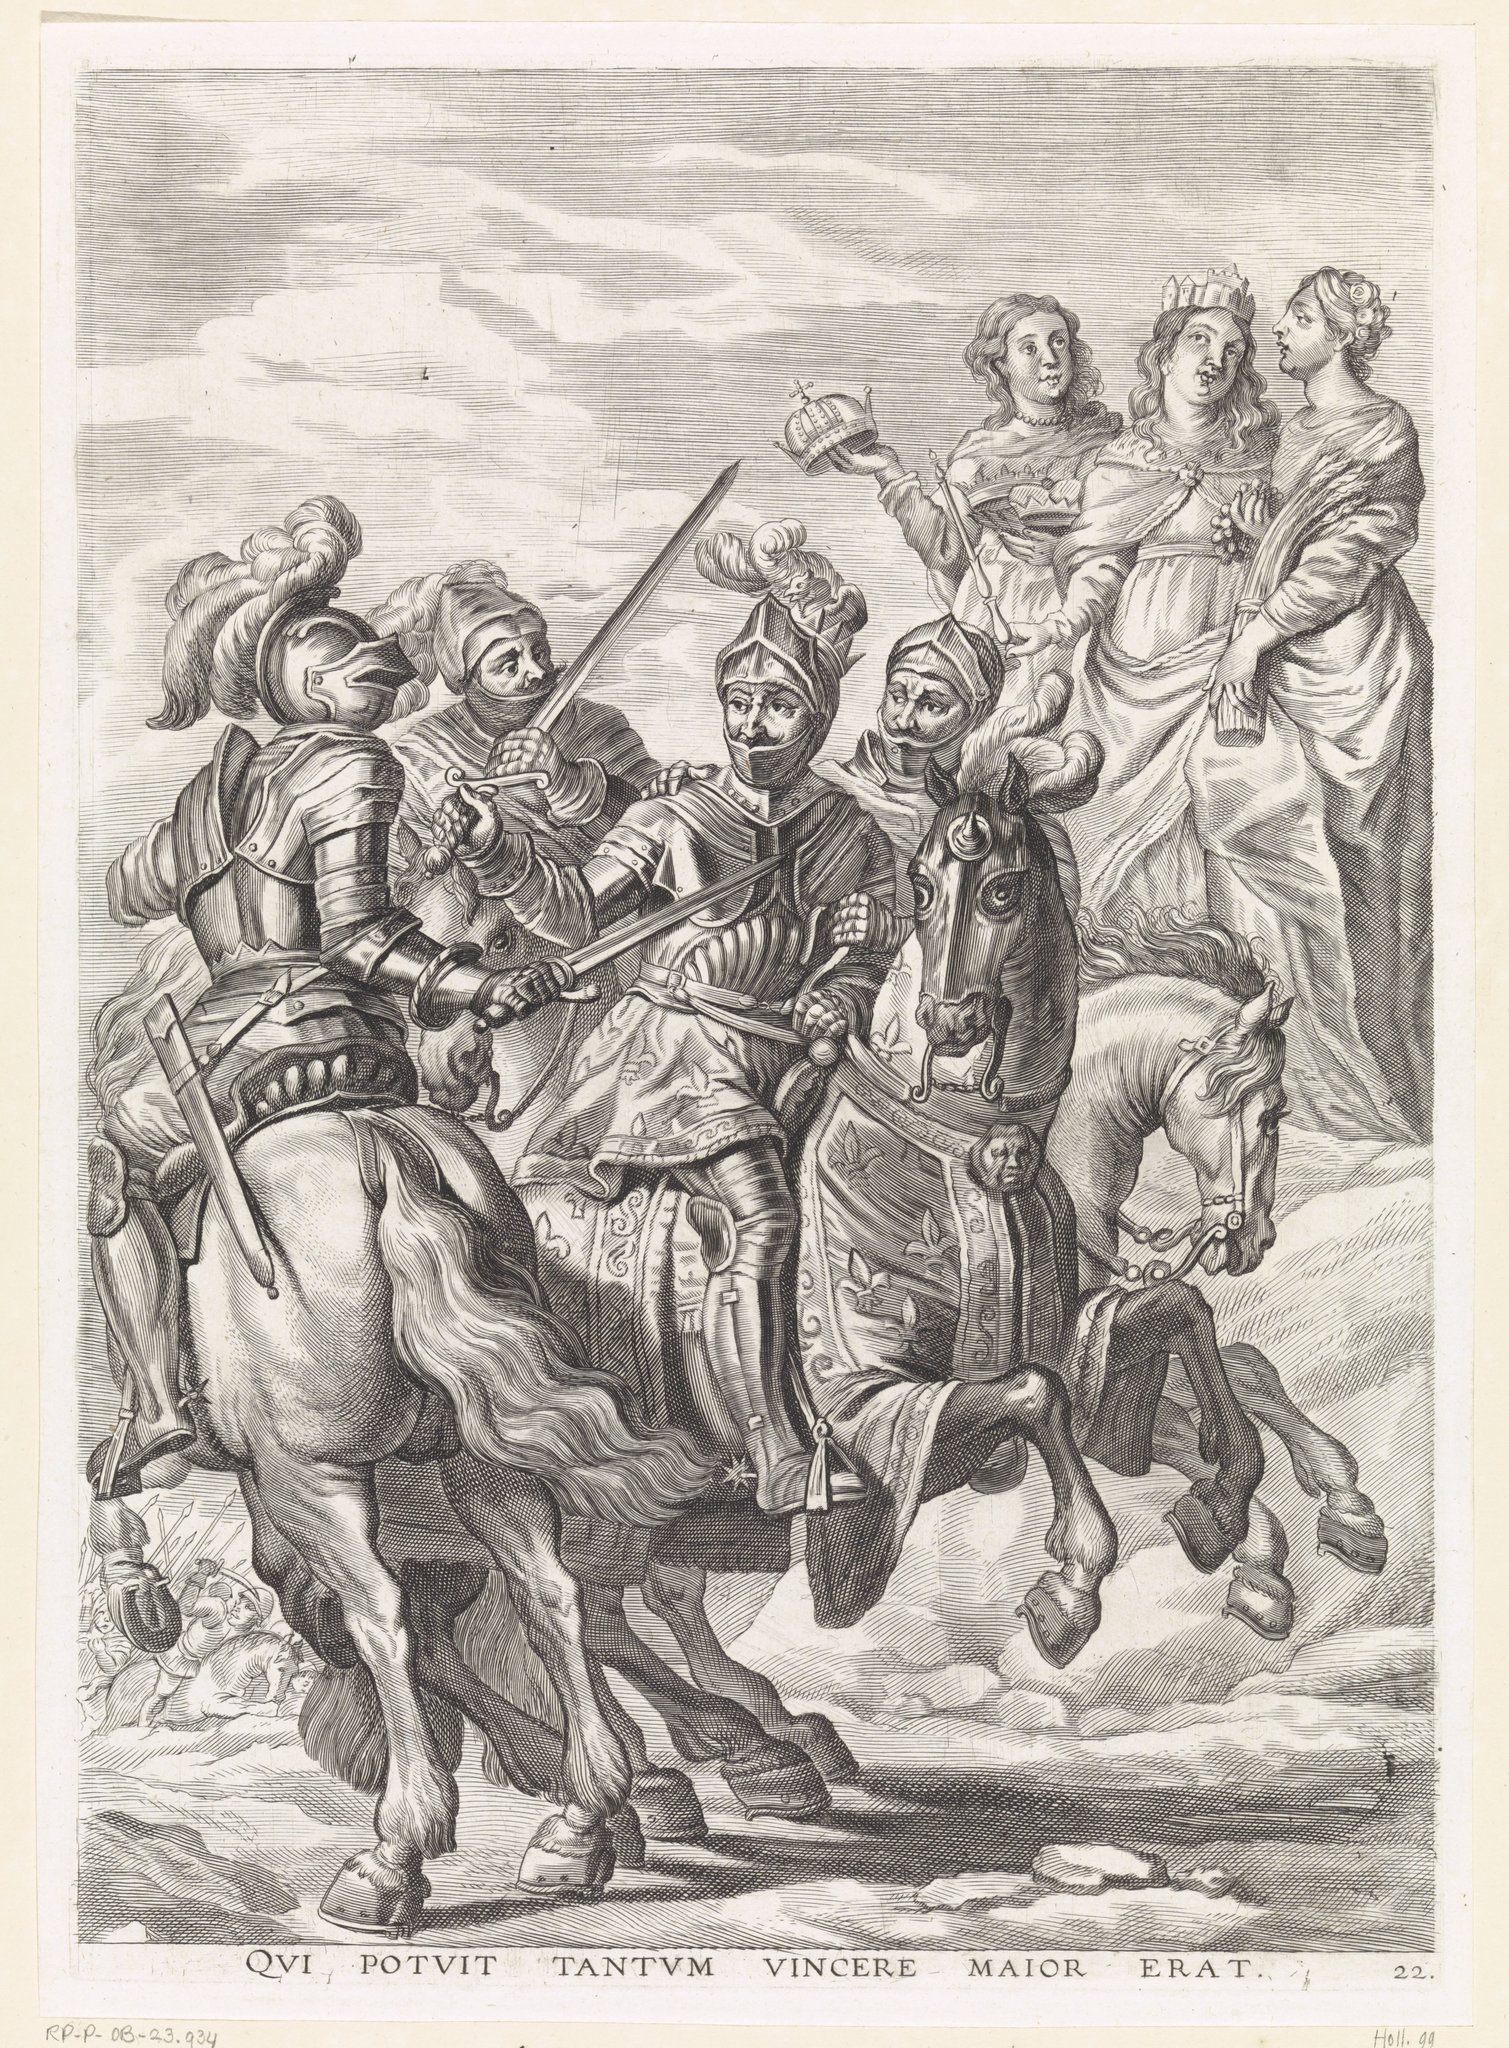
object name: print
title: Overwinning van keizer Karel V bij Ticinum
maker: jacob neefs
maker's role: print maker, publisher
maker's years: 1610-1660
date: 1636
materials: paper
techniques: engraving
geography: antwerp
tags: ghent, charles v (holy roman emperor and king of spain), battle, fighting in general (+ cavalry, horsemen), abundance; 'abondanza', 'abondanza maritima' (ripa) (+ clothed), crown (symbol of sovereignty)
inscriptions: collector's mark: Lugt 240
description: Overwinning van Karel V op de Fransen tijdens de Slag bij Pavia (Ticinum) en de gevangenneming van de Franse koning Frans I, 24 februari 1525. Ruitergevecht, op de achtergrond kijken drie allegorische vrouwenfiguren toe. Voorstelling links op de voorzijde van de triomfpoort Arcus Caroli op de Vrijdagmarkt. Een vrouw met drie kronen in haar handen, een vrouw met een gebouw op haar hoofd en een kandelaar in haar hand en de Overvloed als een vrouw met een korenschoof en druiventros. Prent maakt deel uit van een serie, die de uitgave van de beschrijving van de intocht van de Kardinaal Infant Ferdinand van Oostenrijk te Gent op 28 januari 1635 als de nieuwe landvoogd voor de Spaanse Nederlanden illustreert.